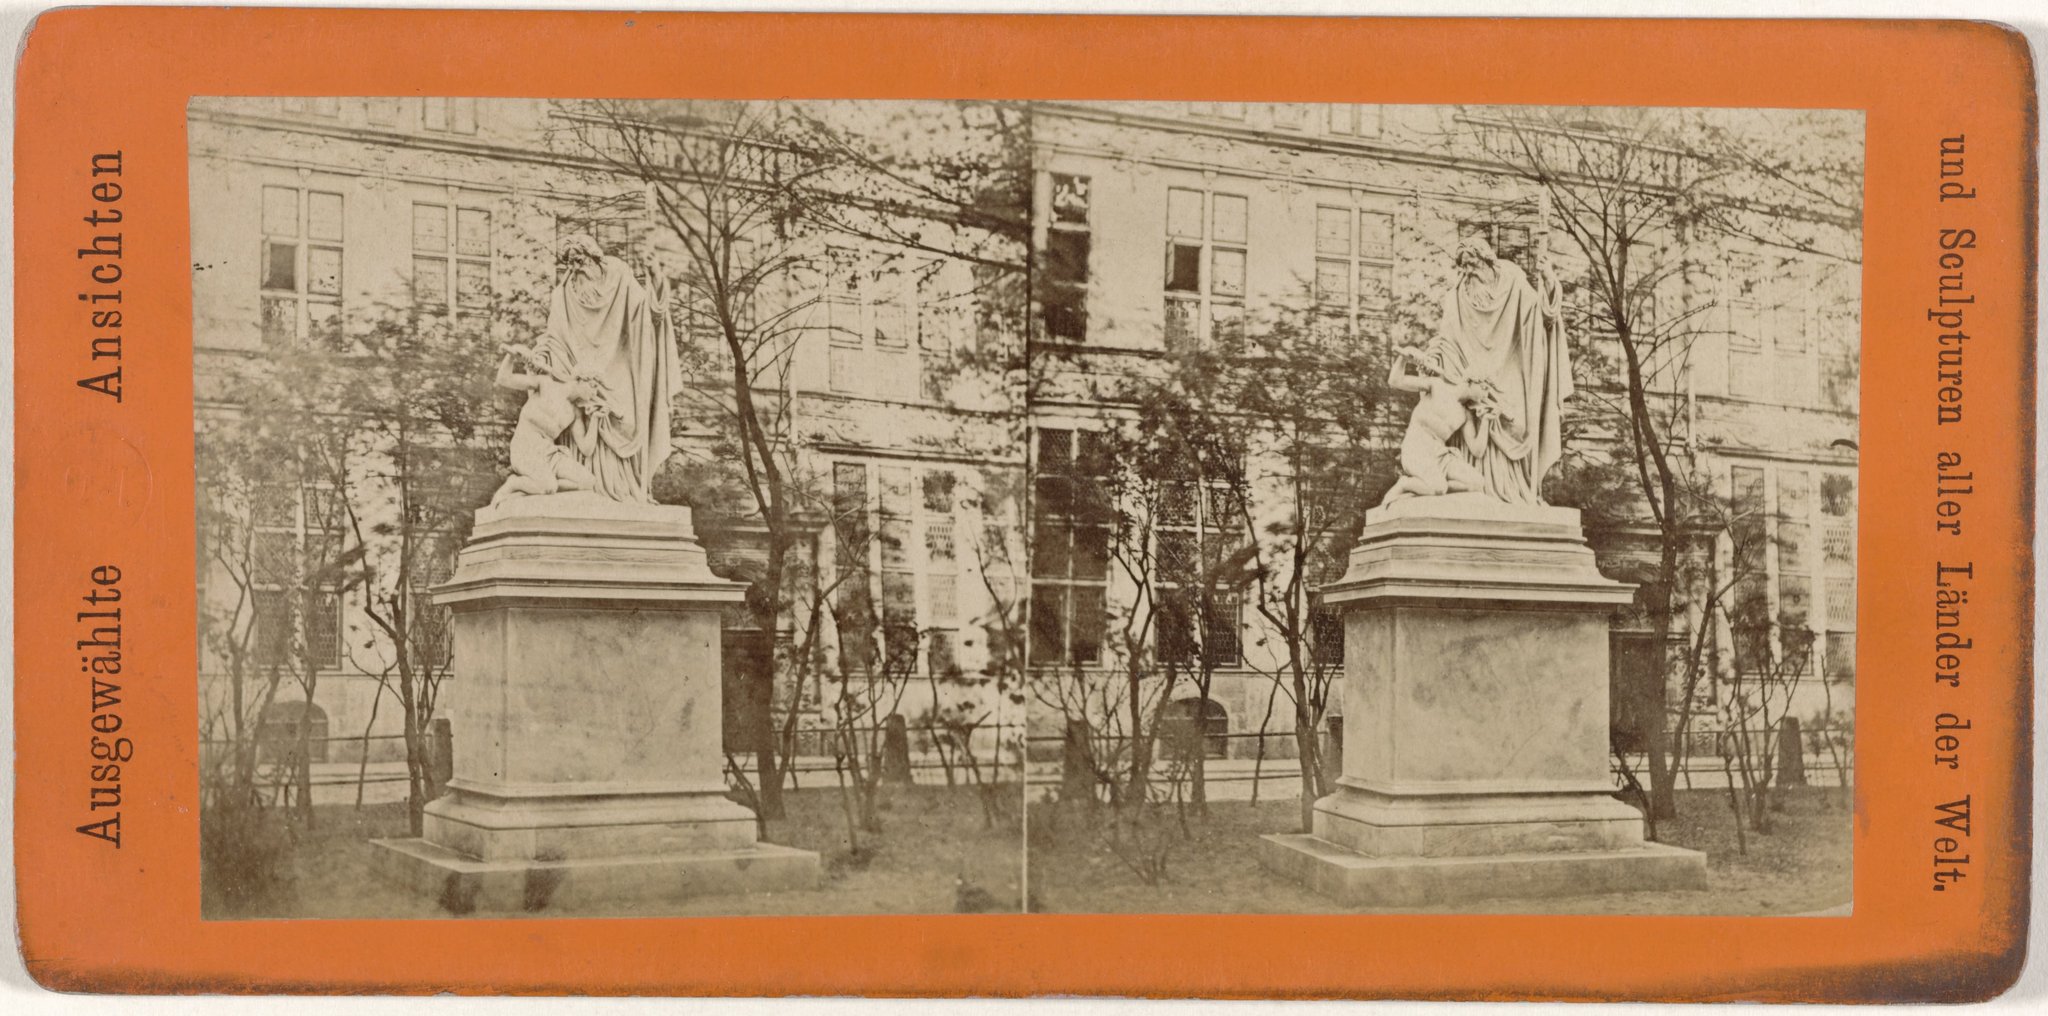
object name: stereograph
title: Bremen, Die Aresgaristatue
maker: o.j.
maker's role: fotograaf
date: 1873-1890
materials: cardboard, paper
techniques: albumen print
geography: bremen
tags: sculpture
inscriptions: number: ‘802’, number: ‘592’